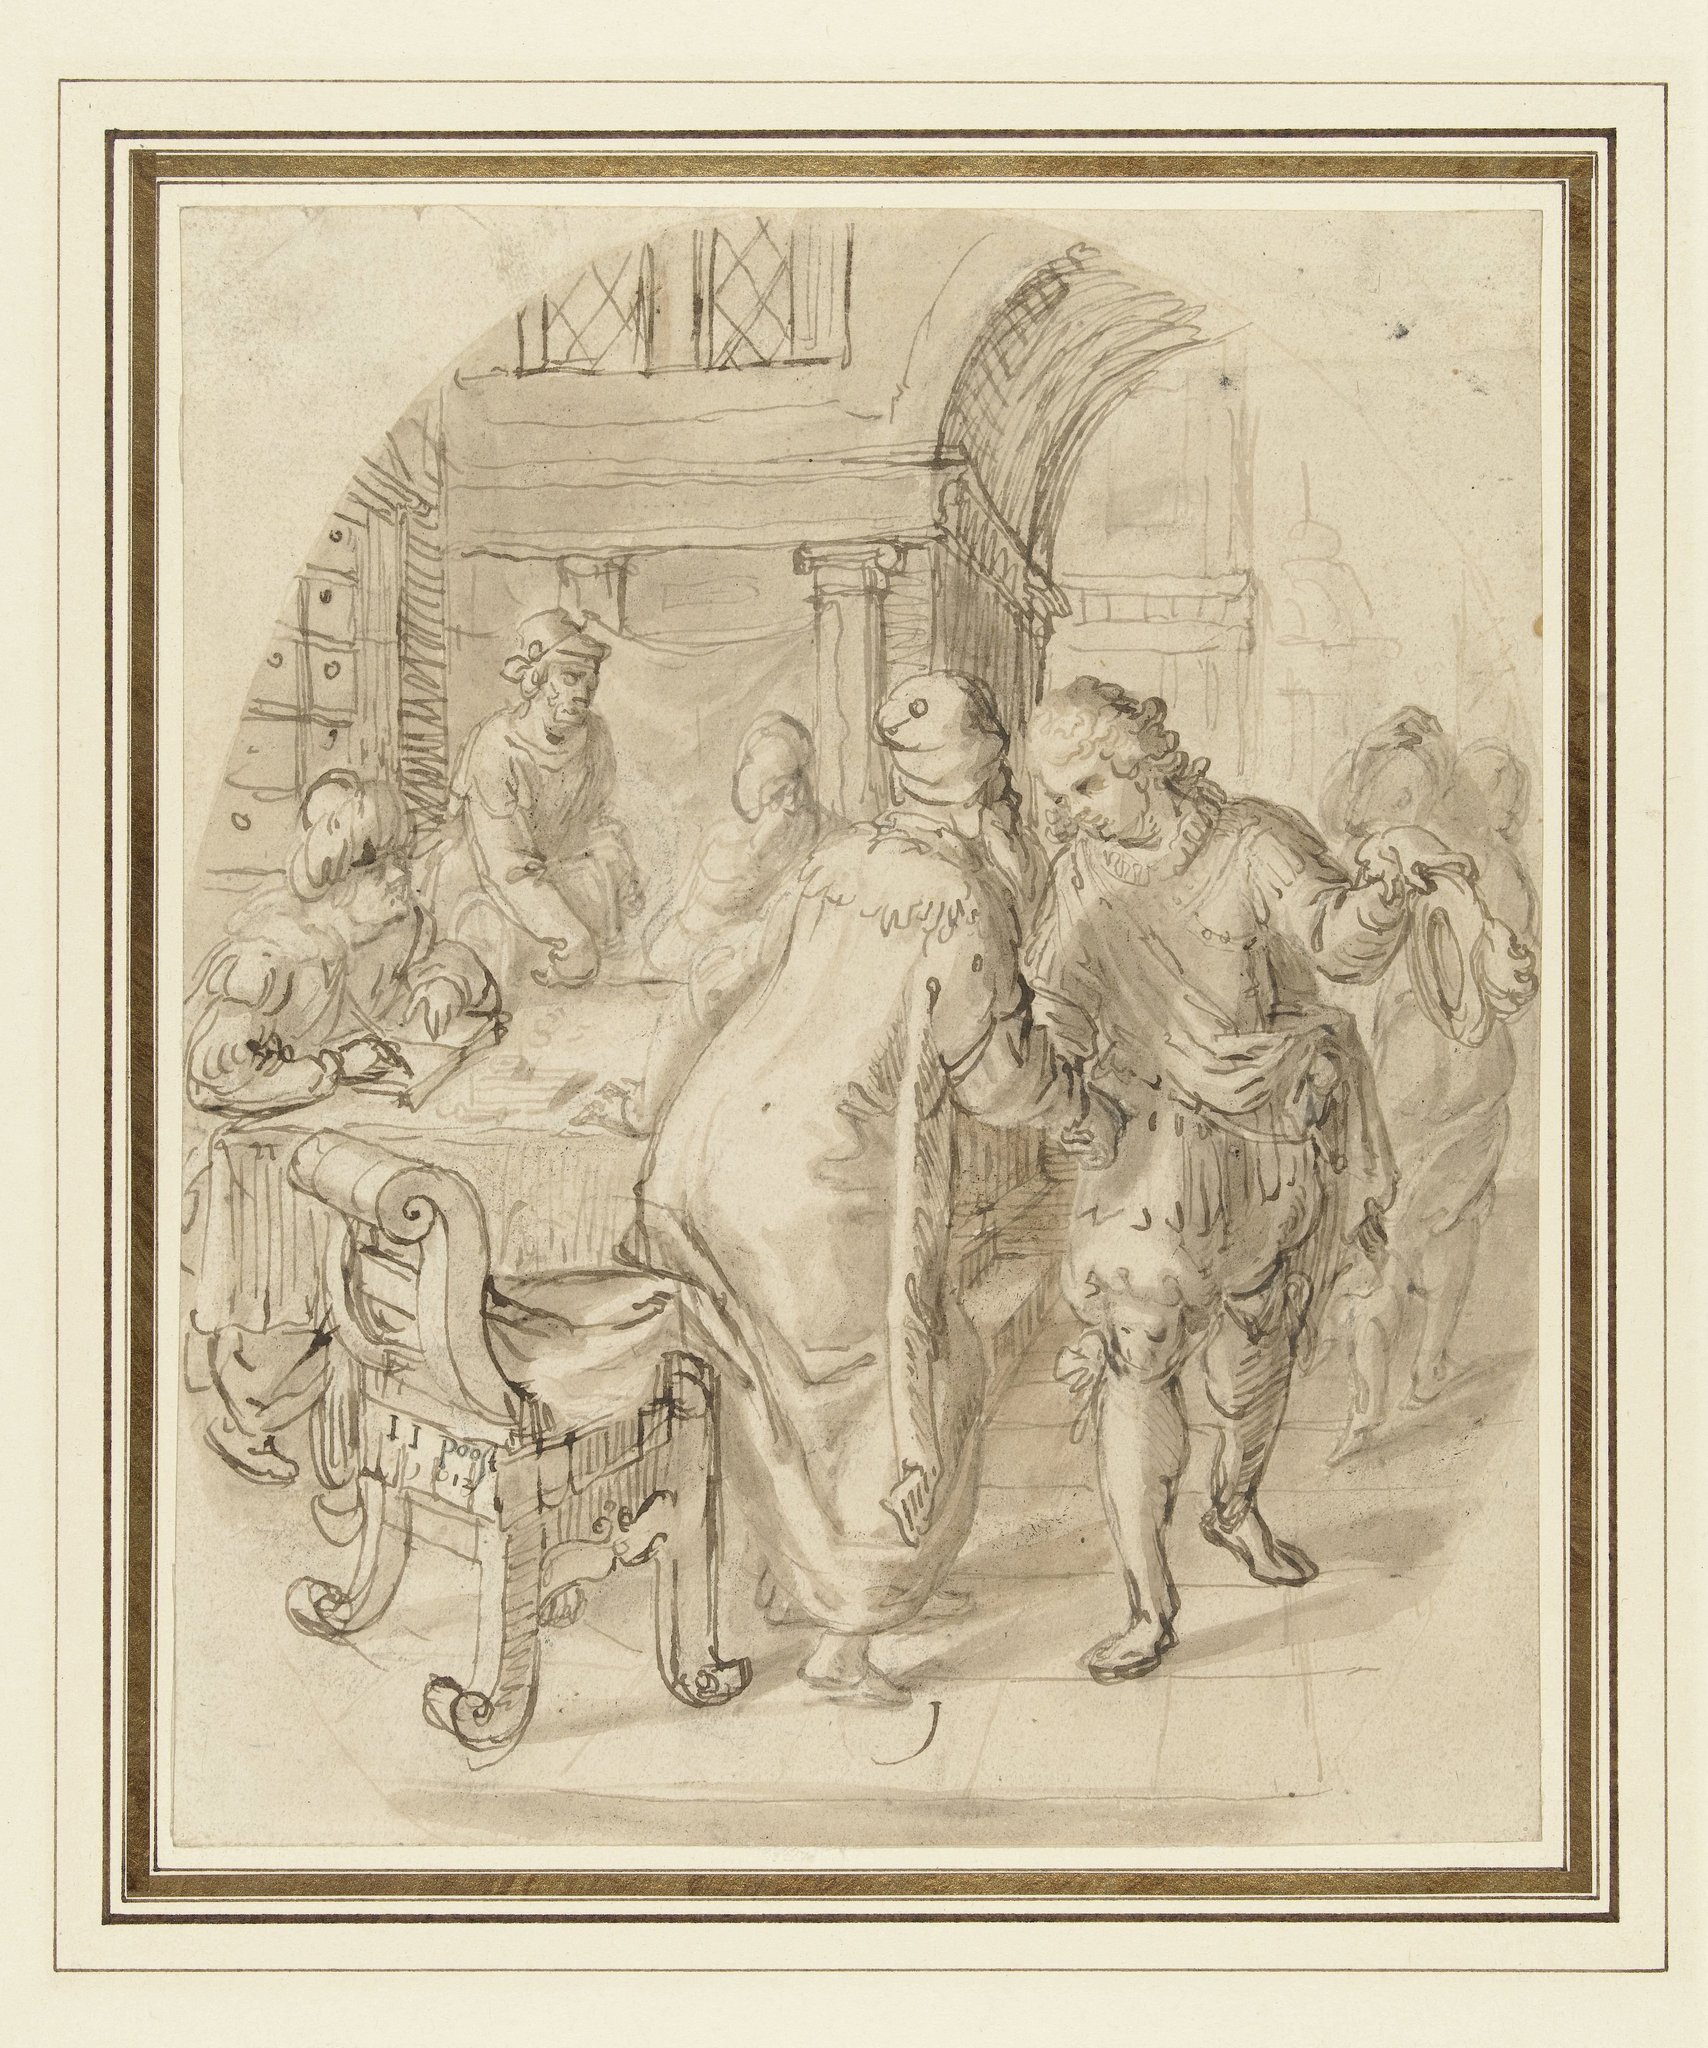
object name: drawing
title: Verloren Zoon ontvangt zijn erfenis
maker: jan jansz. post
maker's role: draughtsman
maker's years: -1614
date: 1612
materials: chalk, ink, paper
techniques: brush, pen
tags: the parable of the prodigal son (luke 15:11-32)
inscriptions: date